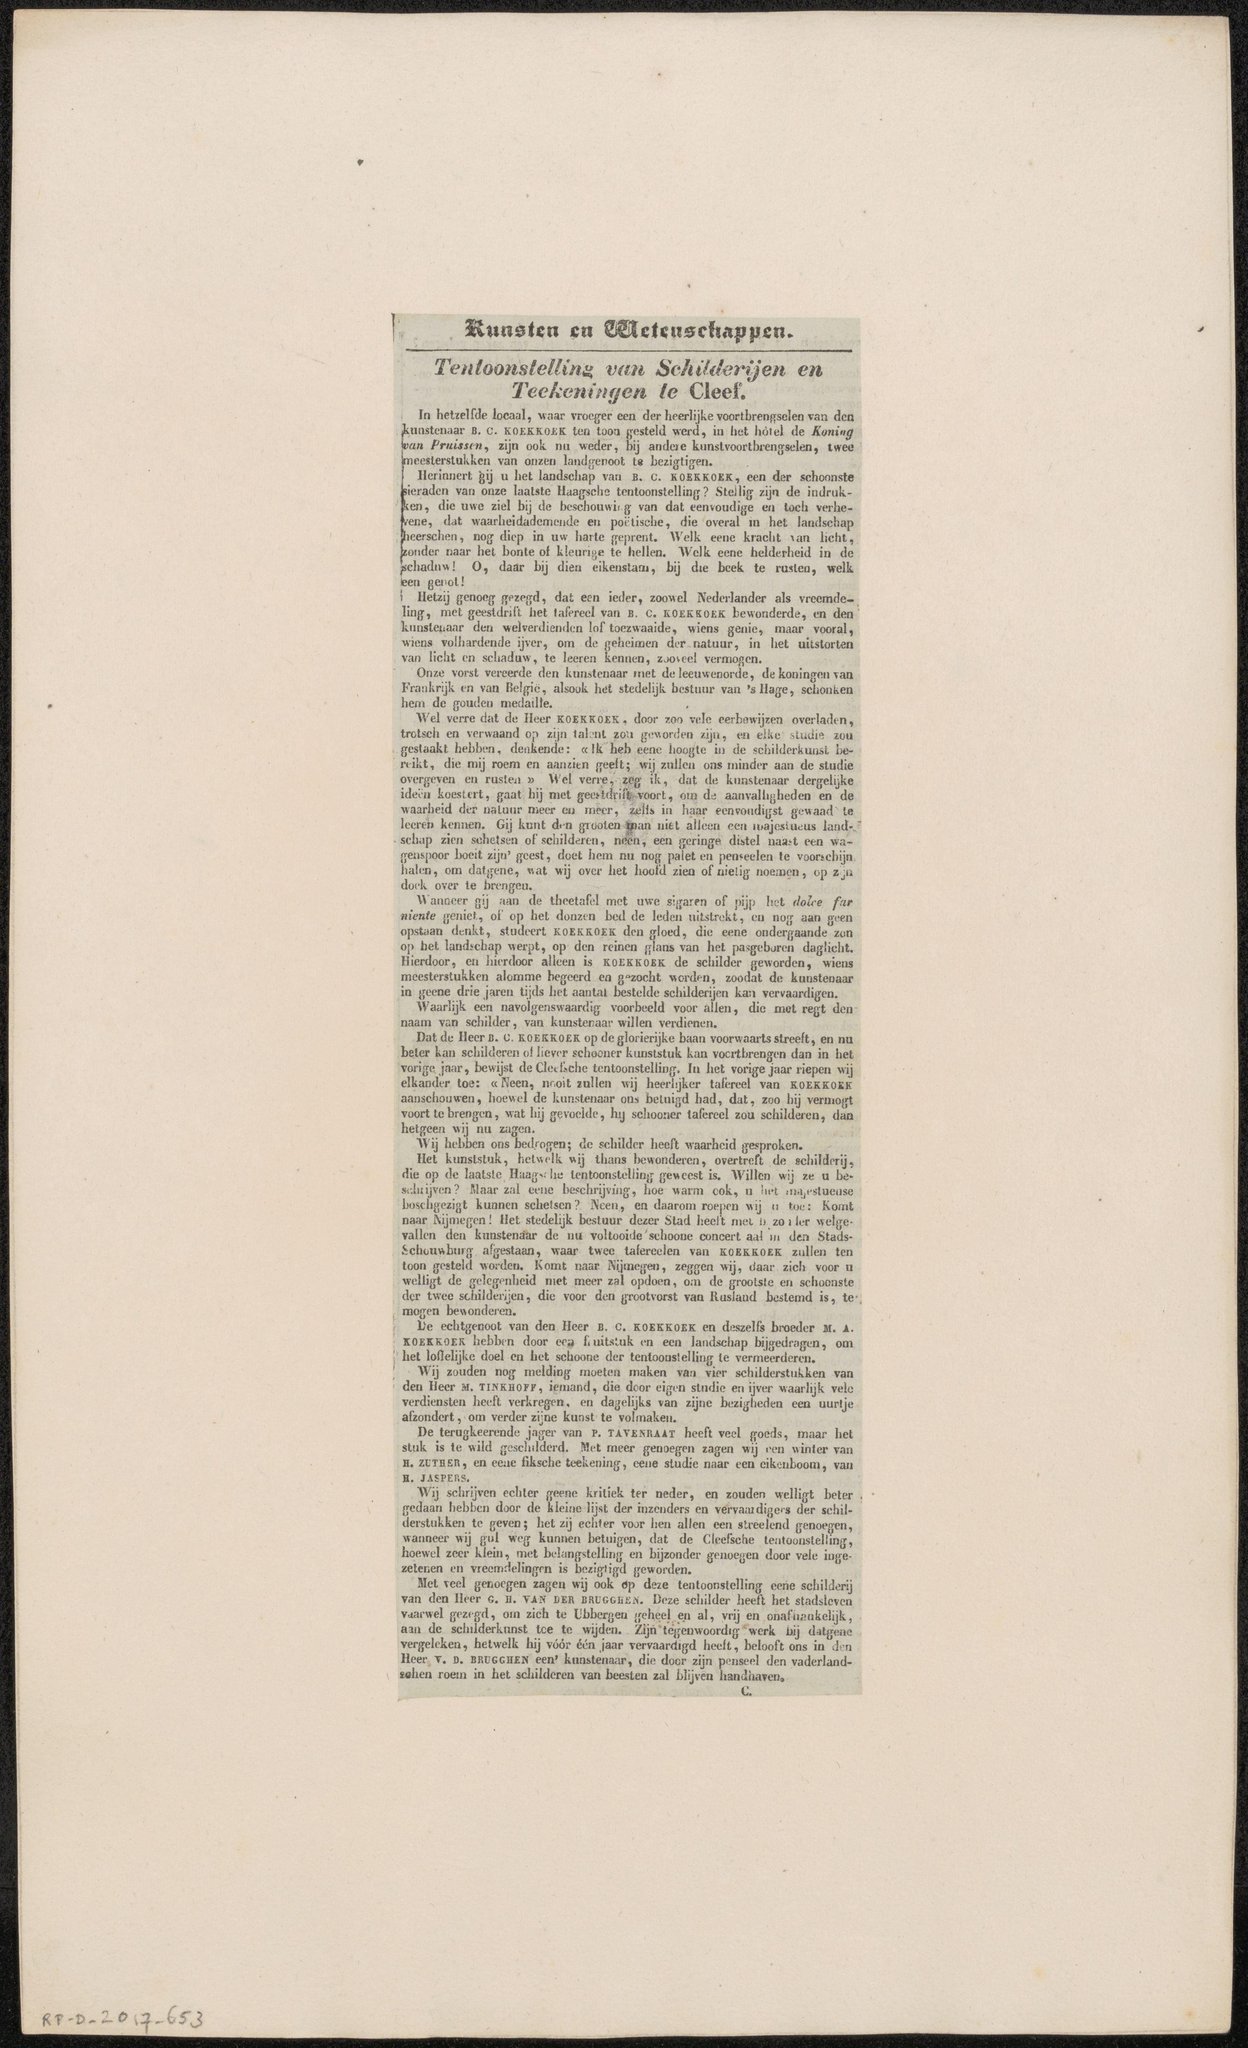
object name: newspaper clipping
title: Krantenknipsel over een tentoonstelling van schilderijen en tekeningen in Kleef van Barend Cornelis Koekkoek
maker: Anonymous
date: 1813-1862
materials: paper, ink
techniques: printing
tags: middelburg, cleves, print maker, draughtsman, barend cornelis koekkoek, painting (including book-illumination, miniature-painting)